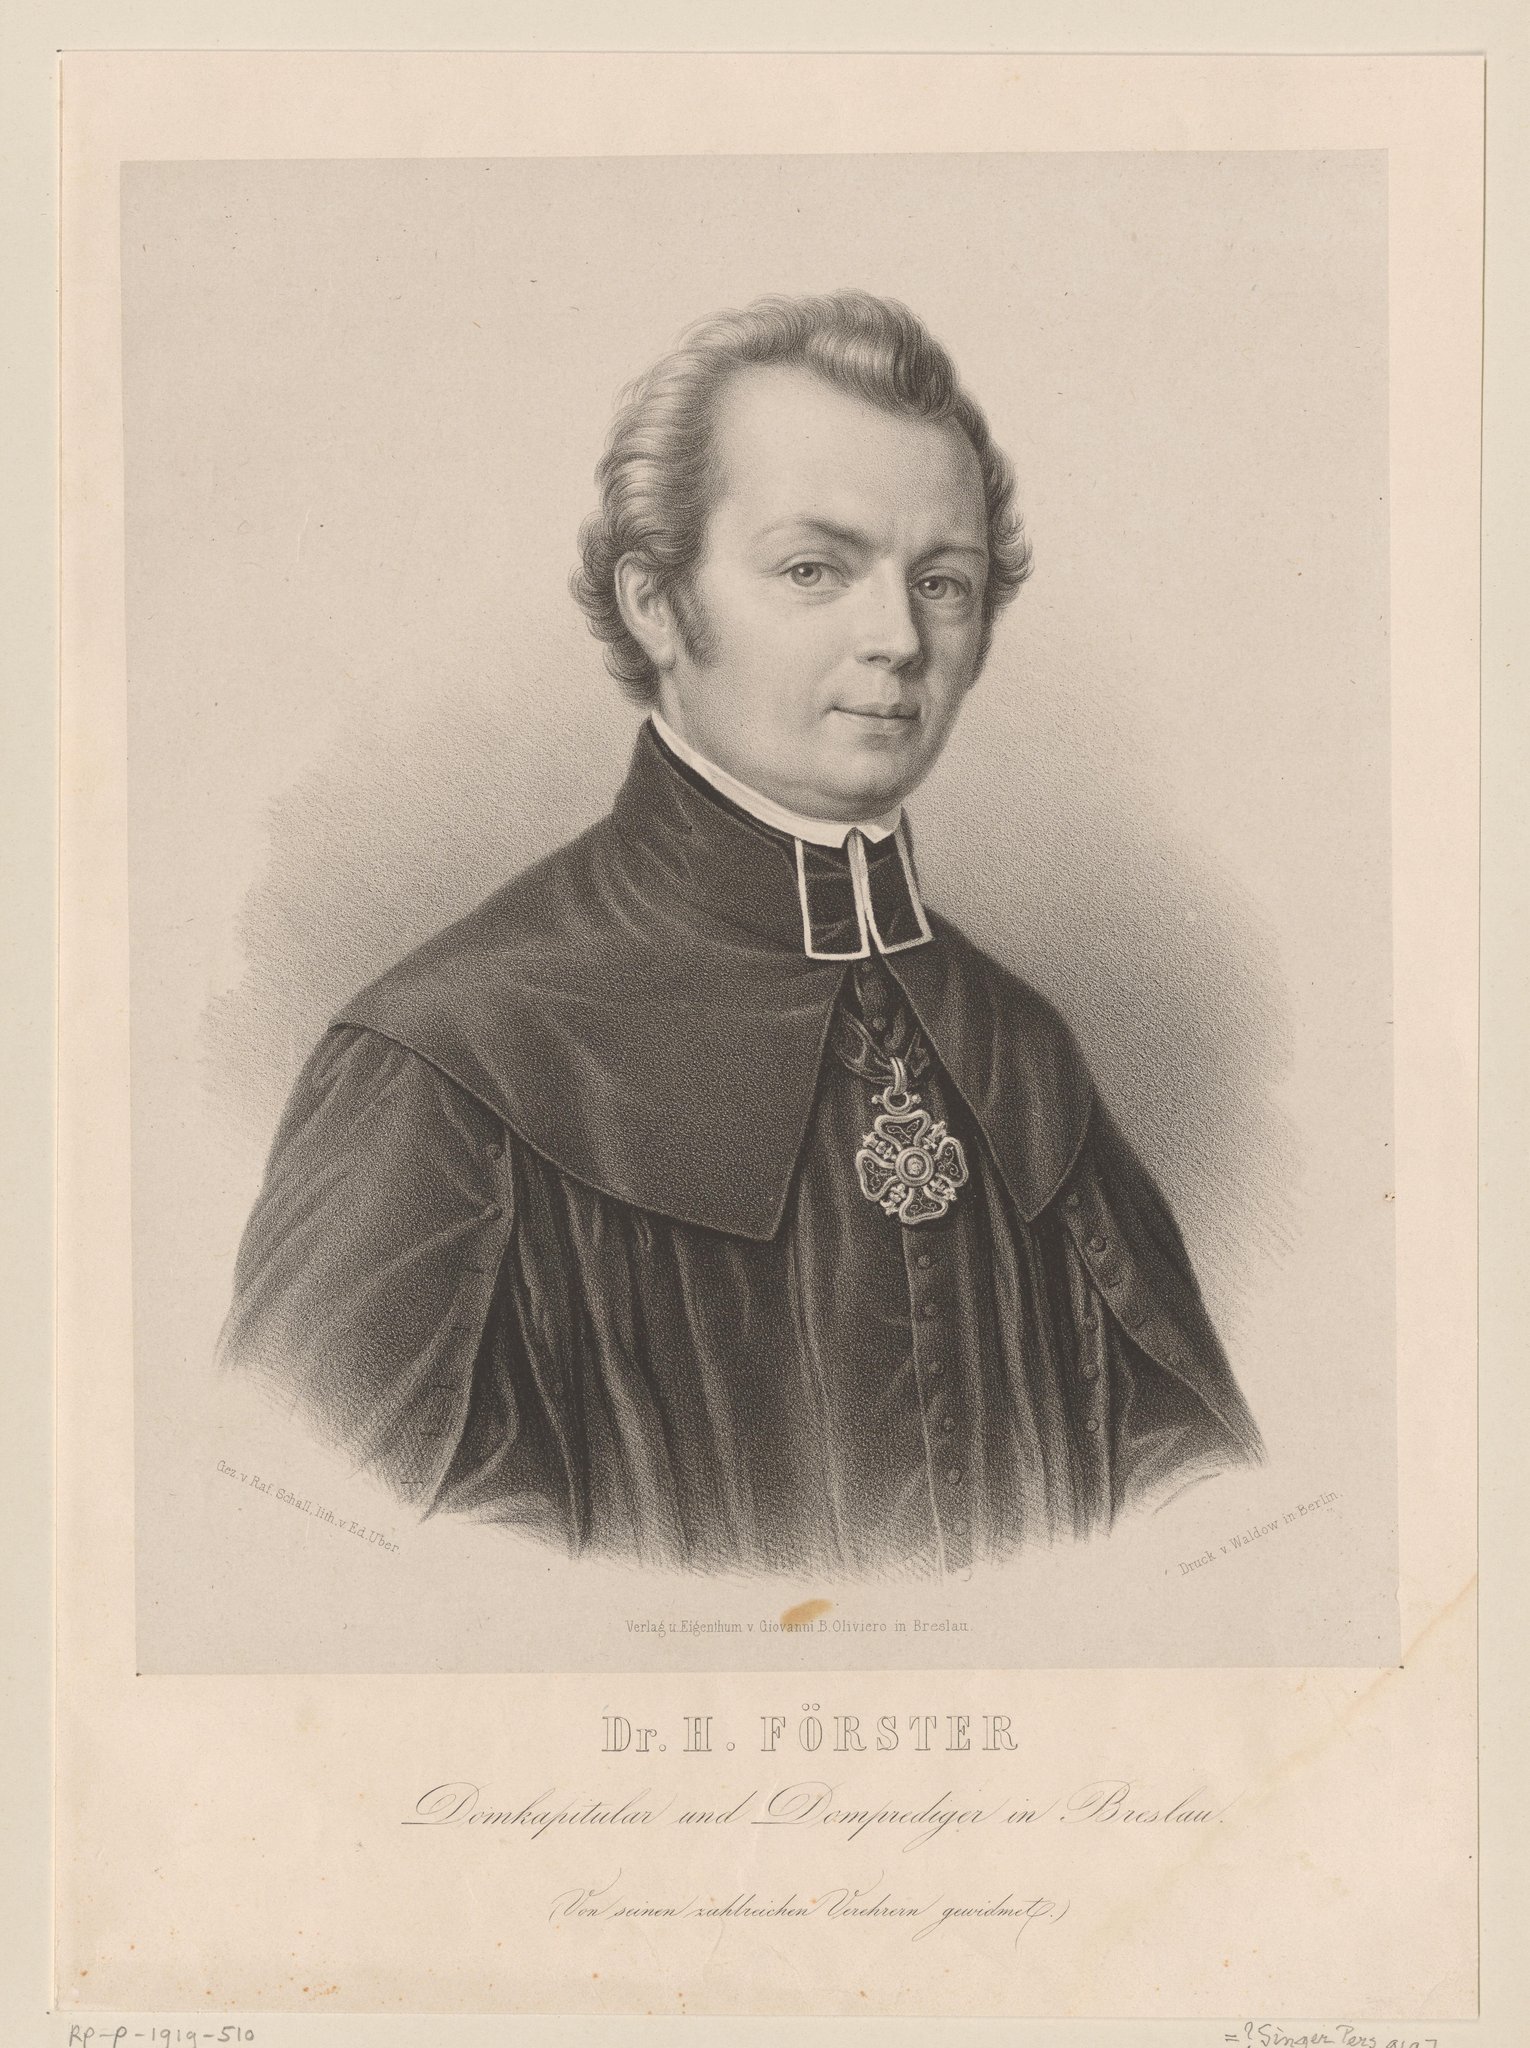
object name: print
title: Portret van Heinrich Förster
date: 1837-1848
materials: paper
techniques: lithograph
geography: breslau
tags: theologian, historical persons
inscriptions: collector's mark: Lugt 2228